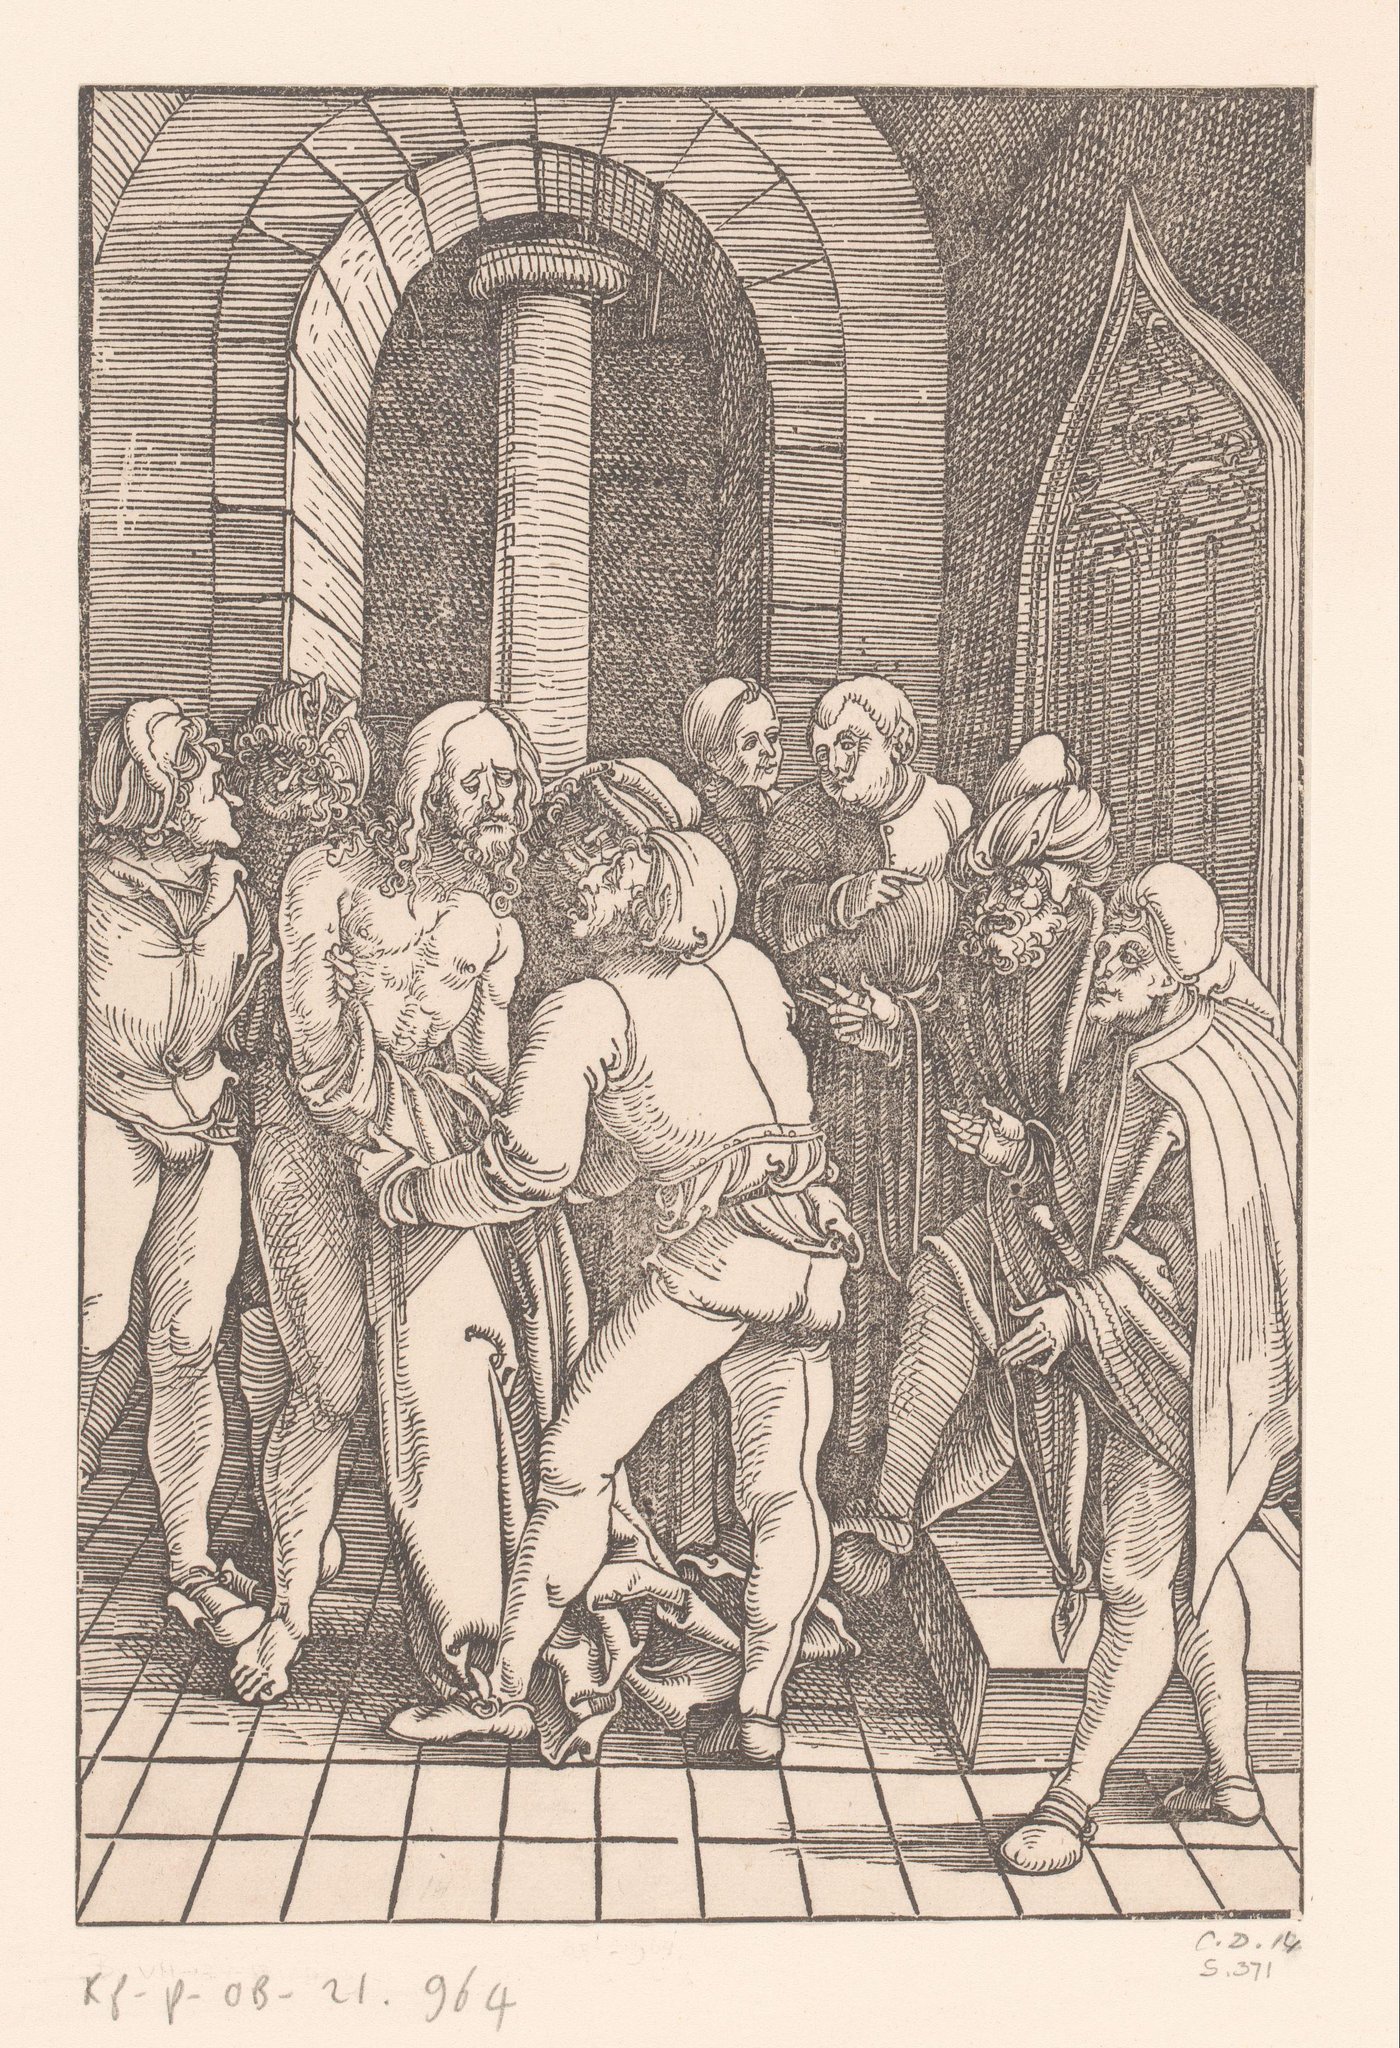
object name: print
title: Ontkleding van Christus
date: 1506-1507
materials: paper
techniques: woodcut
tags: christ disrobed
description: Prent voor het eerst gebruikt in: Speculum Passionis. Neurenberg: Ulrich Pinder, 1507.